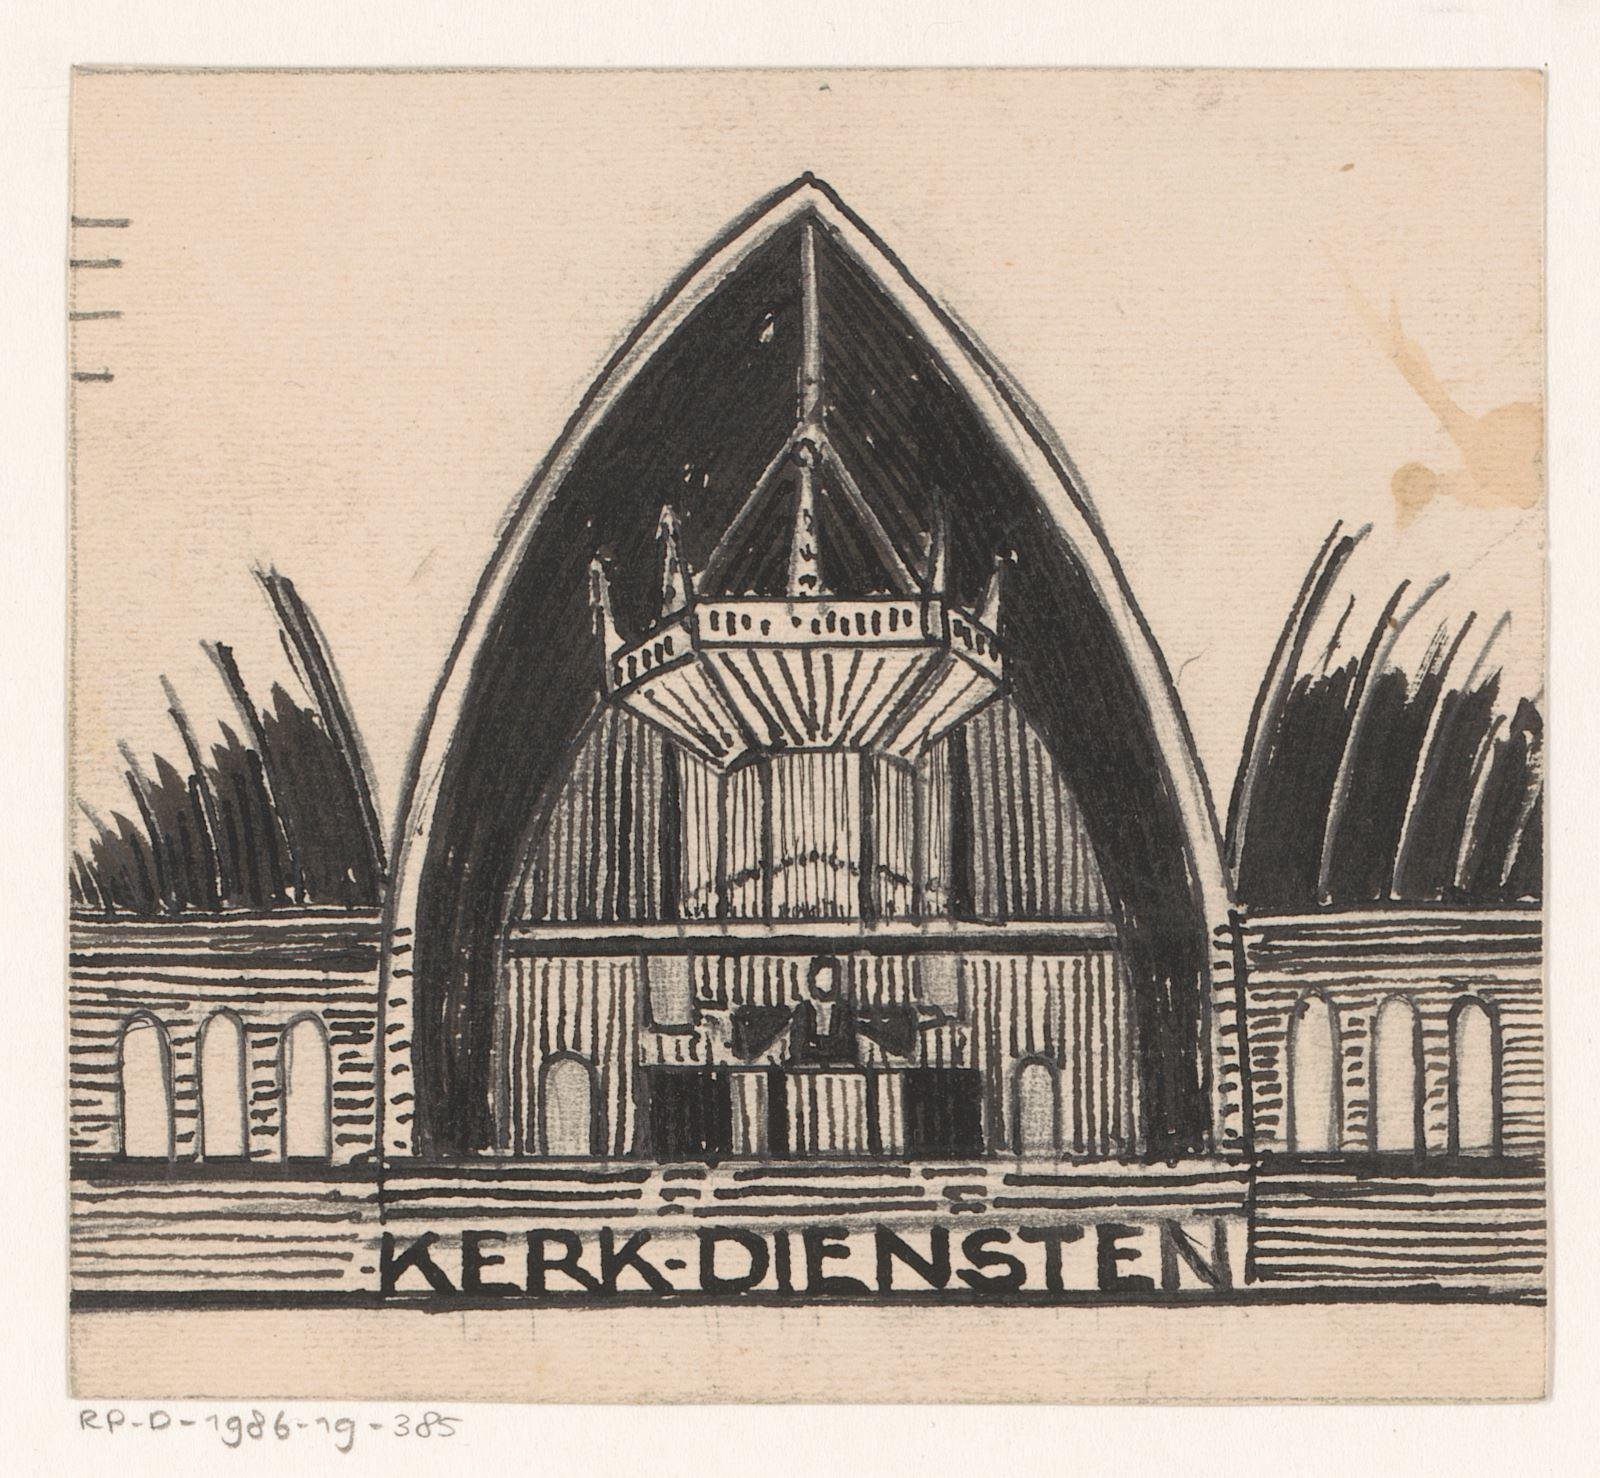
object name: drawing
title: Kerkinterieur met predikant achter de kansel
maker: reinier willem petrus de vries (1874-1953)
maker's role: draughtsman, print maker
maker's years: 1874-1953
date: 1884-1952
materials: ink, paper, pencil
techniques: brush, pen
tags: pulpit, ambo, chancel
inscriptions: collector's mark: ‘R:MVS.’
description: Vermoedelijk een ontwerp voor de Hilversumse afdeling van de Nederlandse Protestantenbond.